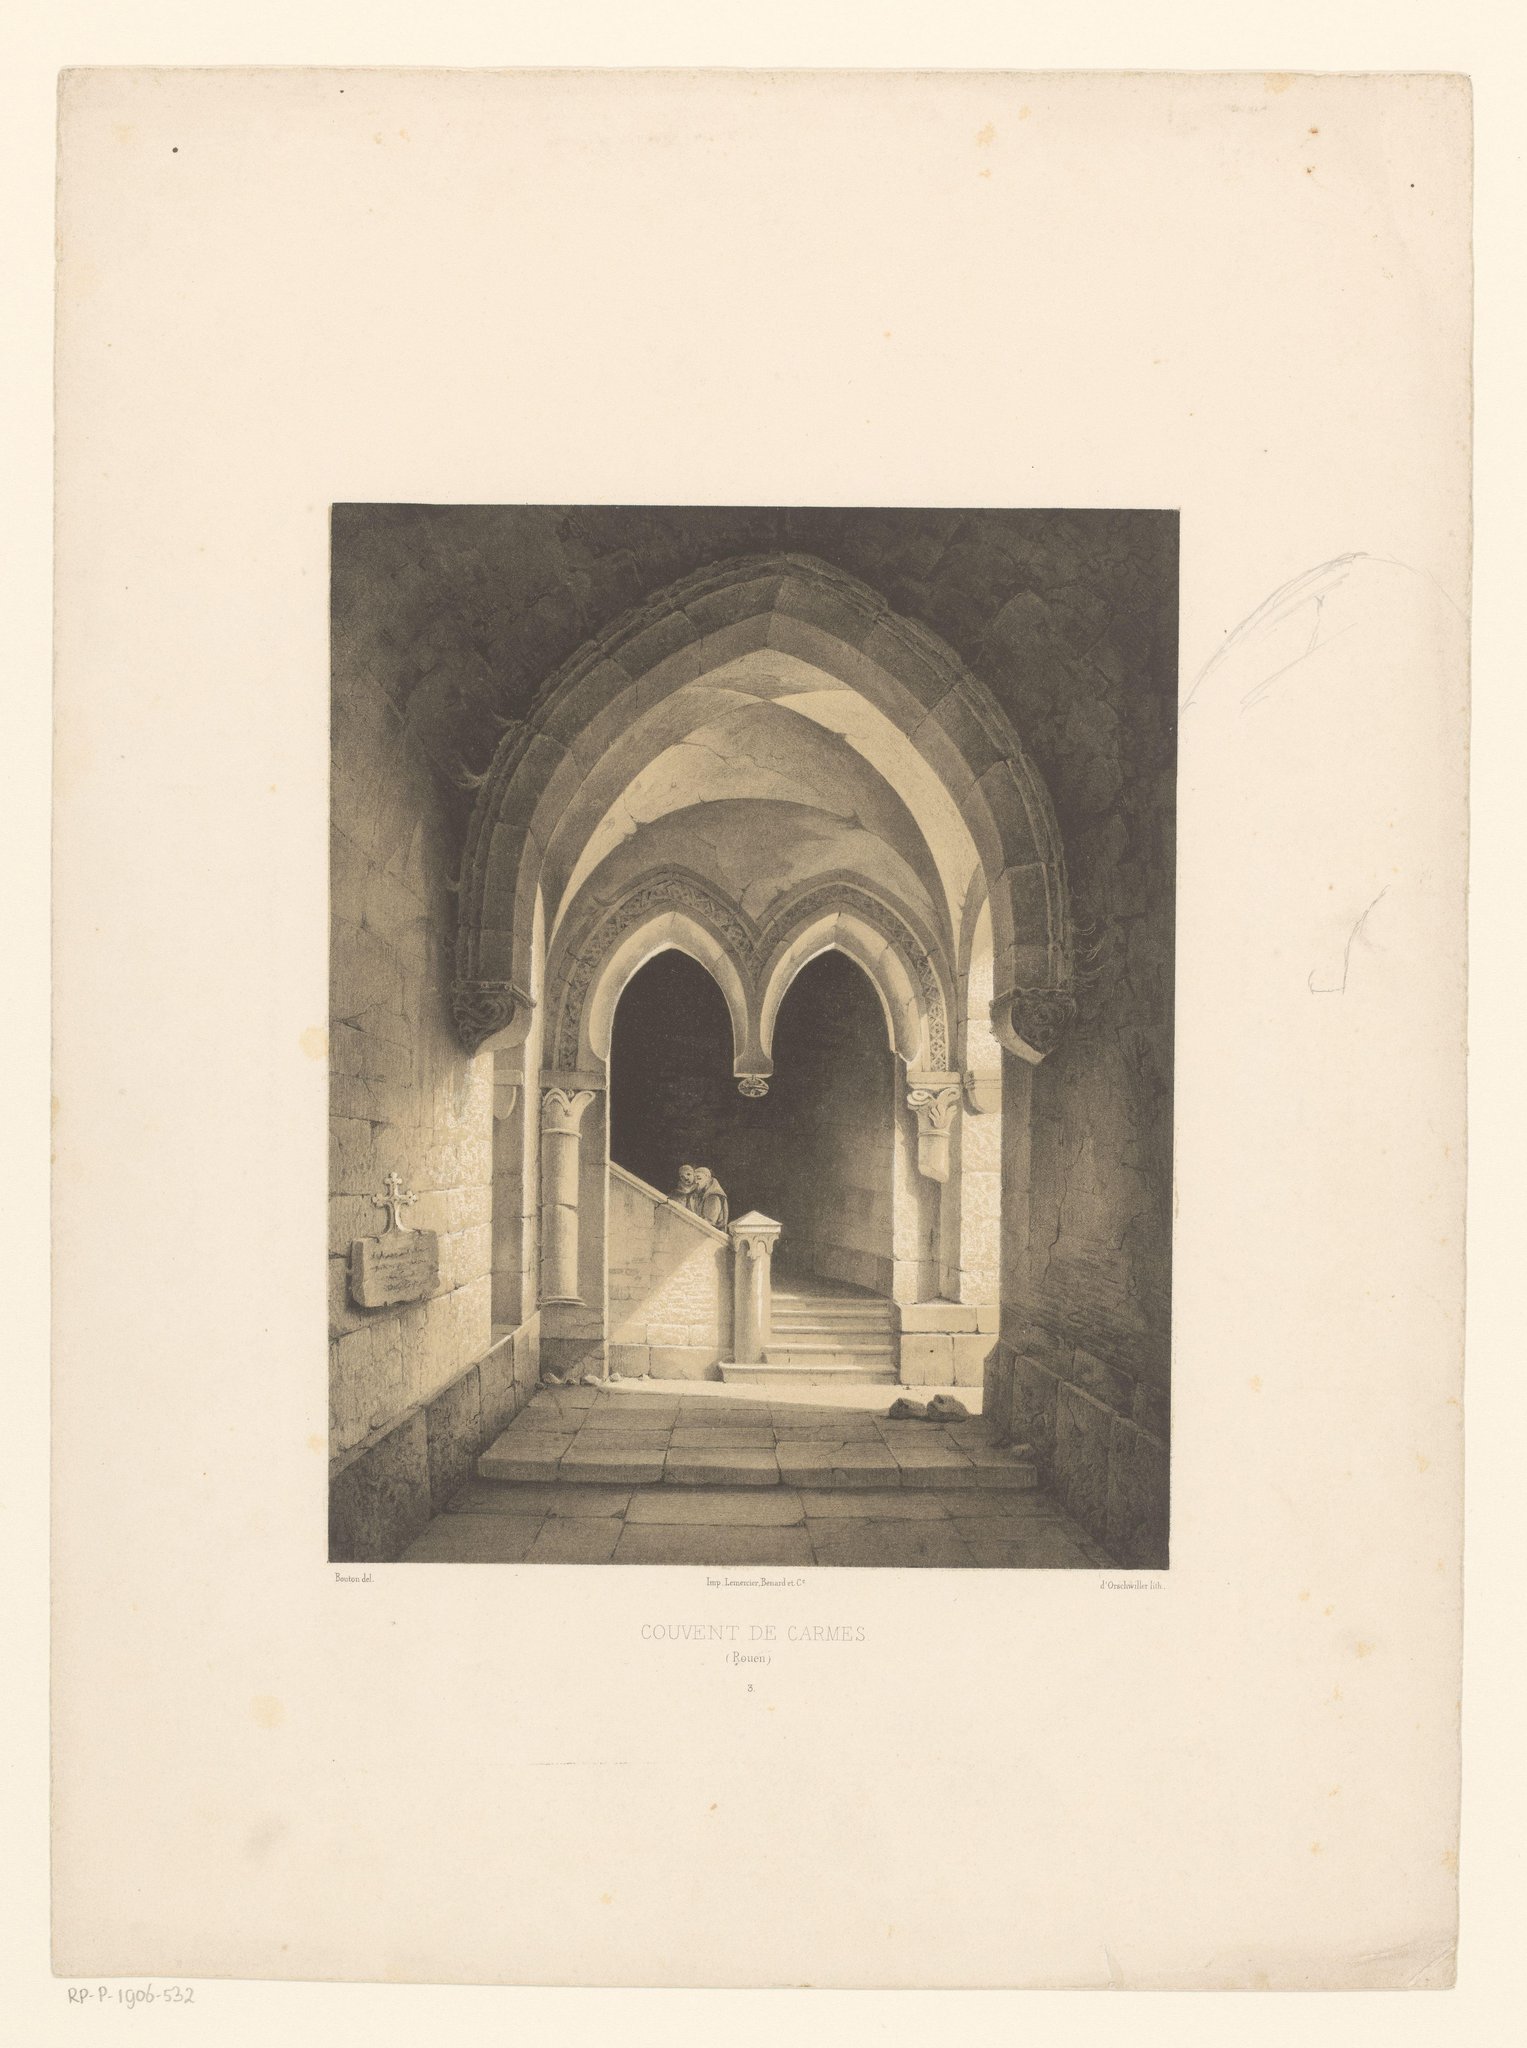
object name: print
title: Interieur van een klooster met twee monniken op de achtergrond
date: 1837-1843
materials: paper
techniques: tone lithography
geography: paris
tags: abbey, monastery, convent ~ roman catholic church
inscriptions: collector's mark: Lugt 2228